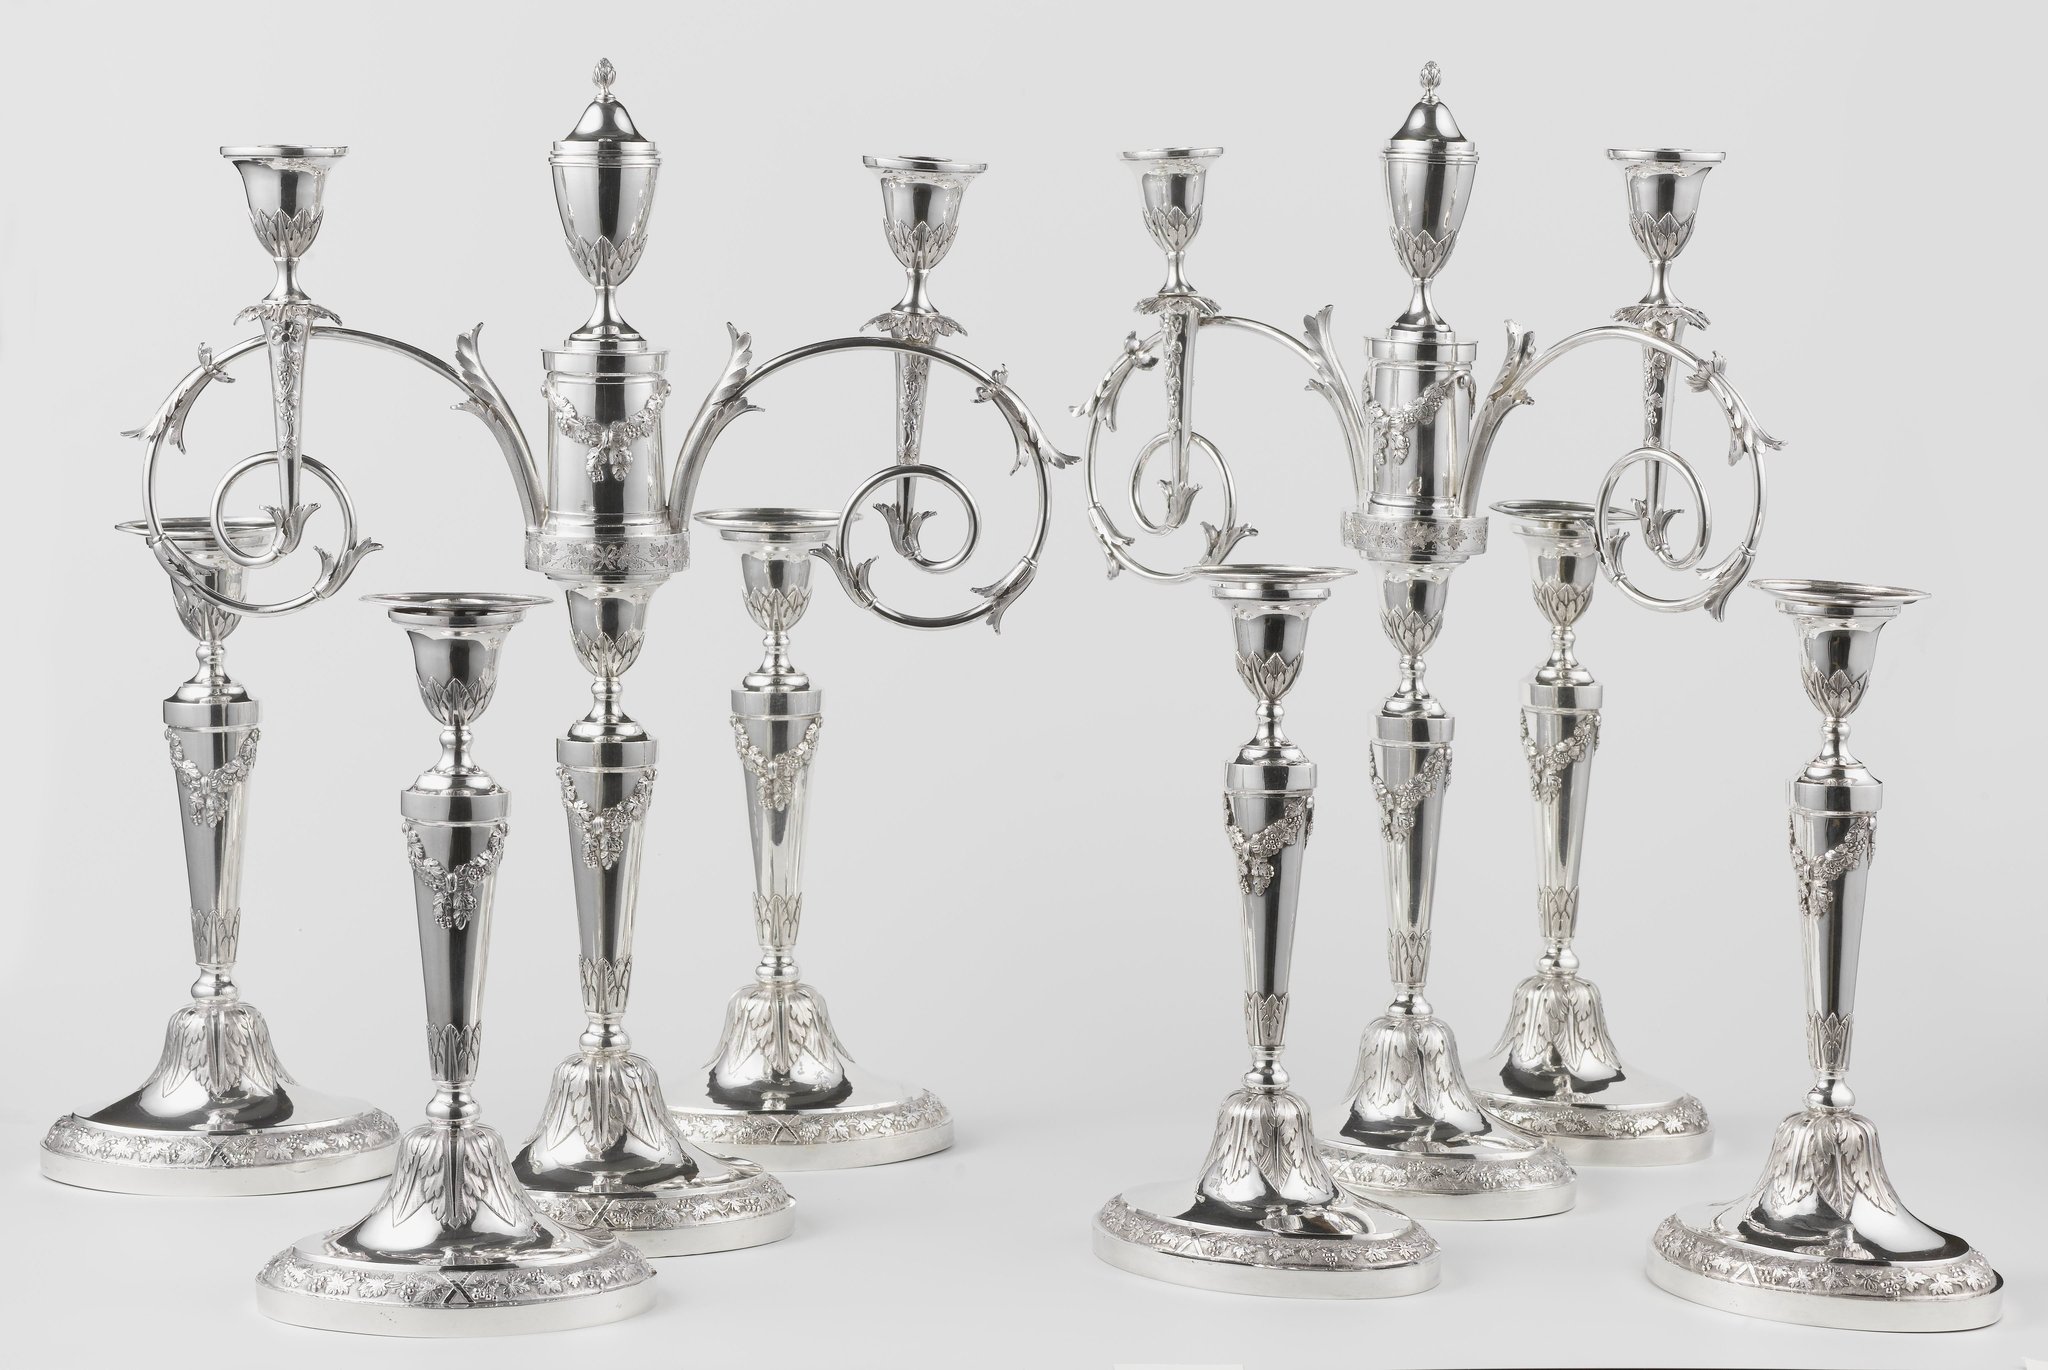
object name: candlestick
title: Kandelaar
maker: francois marcus simons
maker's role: silversmith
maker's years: 1750-1828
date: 1803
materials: silver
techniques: casting, metalworking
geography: the hague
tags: foliage, tendrils, branches ~ ornament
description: Dinner service. Silver, parcel gilt. The Hague, 1803 and 1804, by François Simons. The Government of the Batavian Republic presented this service to I.J.A. Gogel (1765 - 1821) in 1804 in recognition of his financial services to the country. Gogel was a prominent patriot, minister of finance under King Louis Napoleon and subsequently financial advisor to King